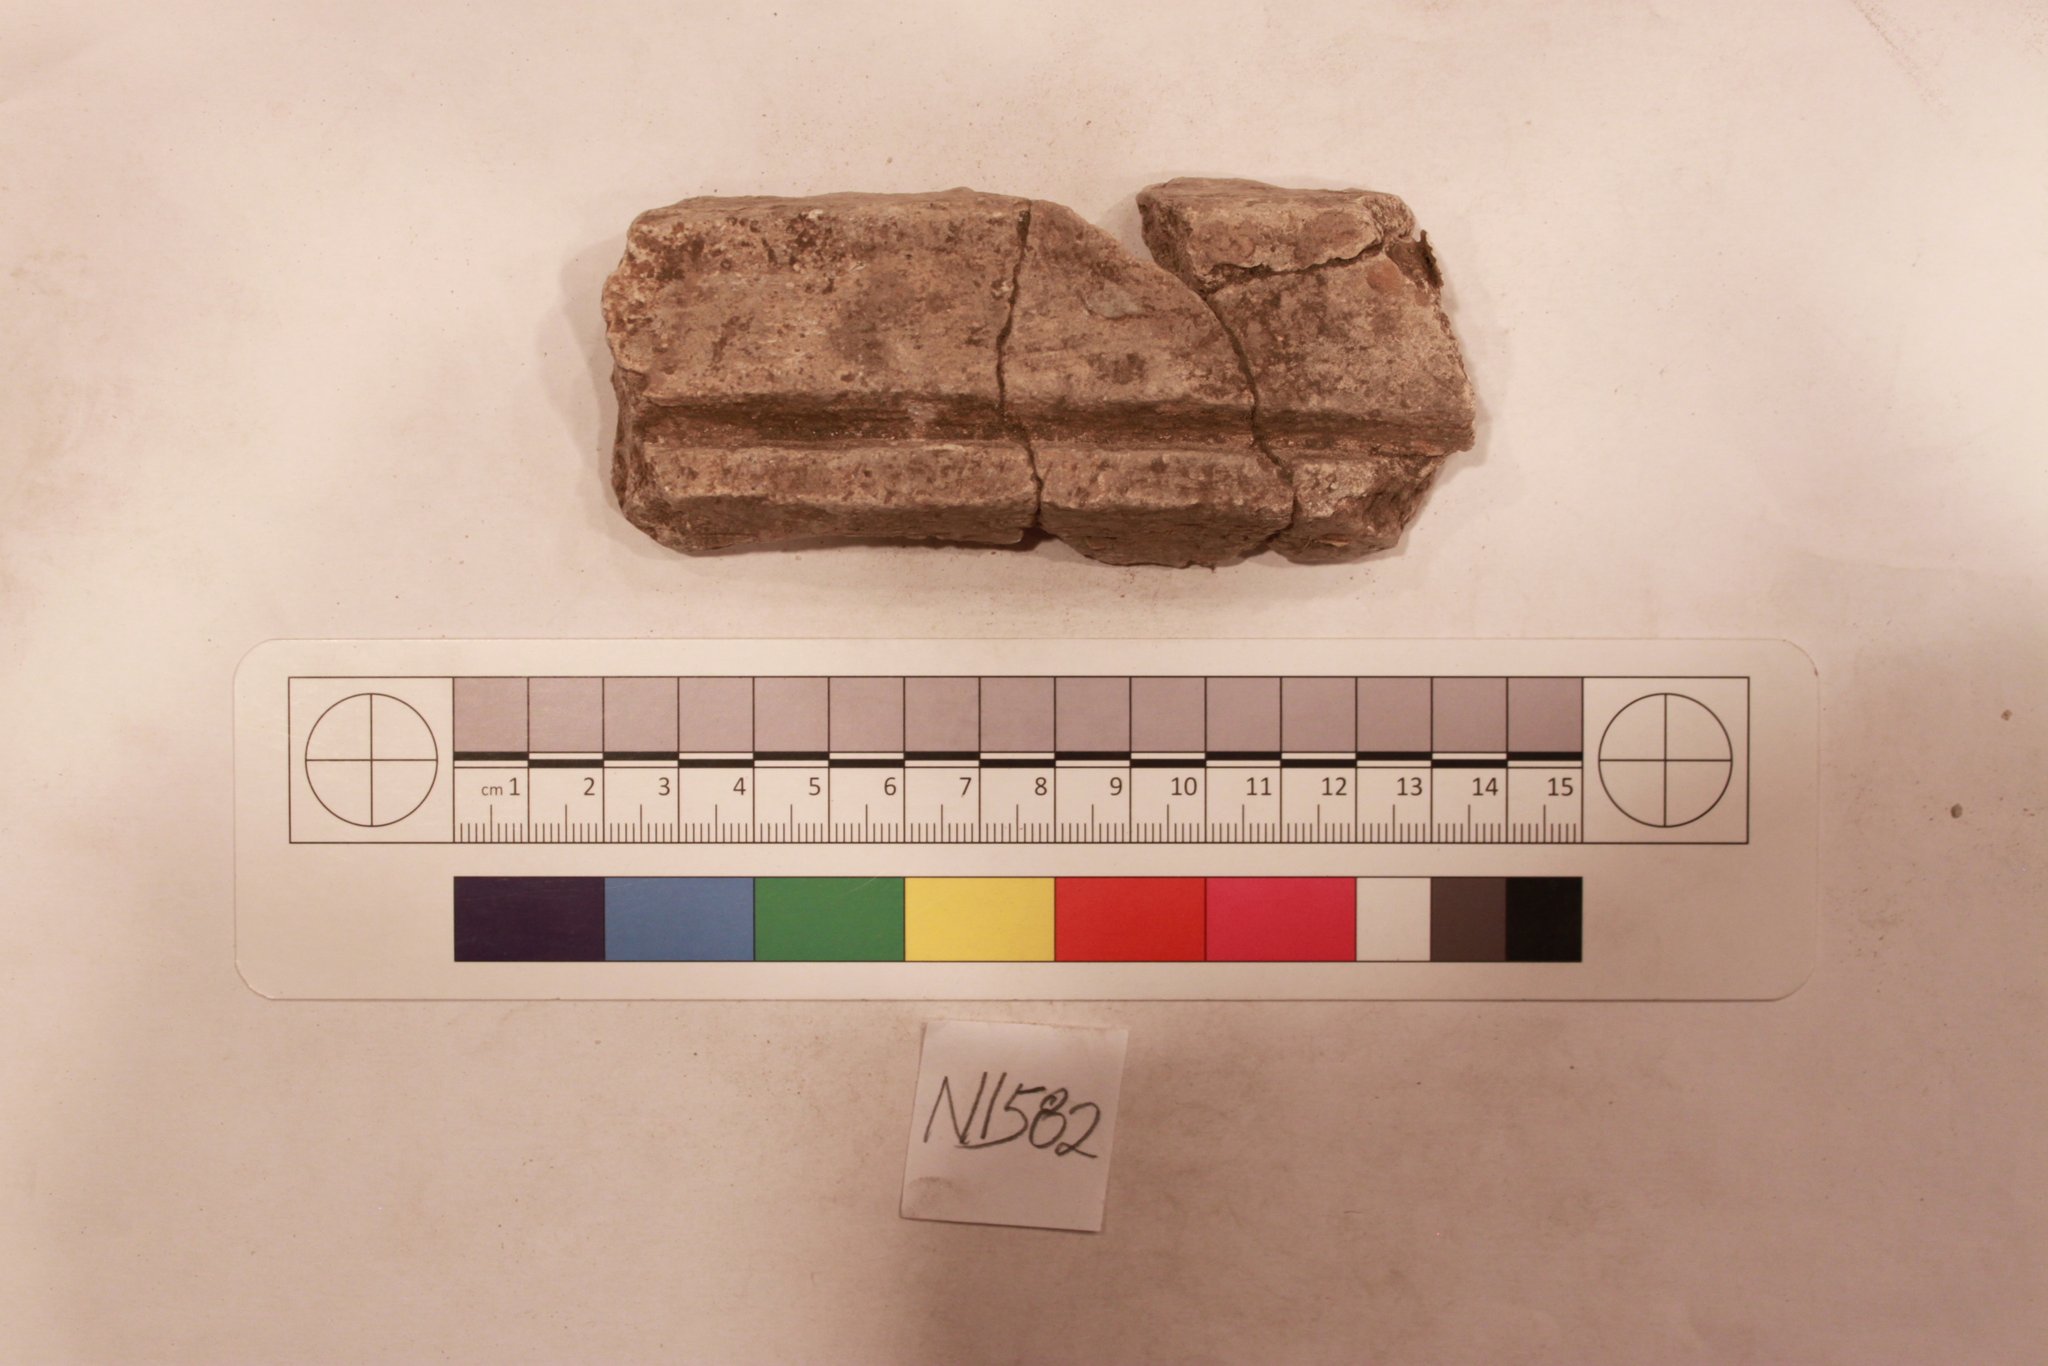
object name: fragment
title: Stucco Fragment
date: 701-1200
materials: plaster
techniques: carving, painting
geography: iran